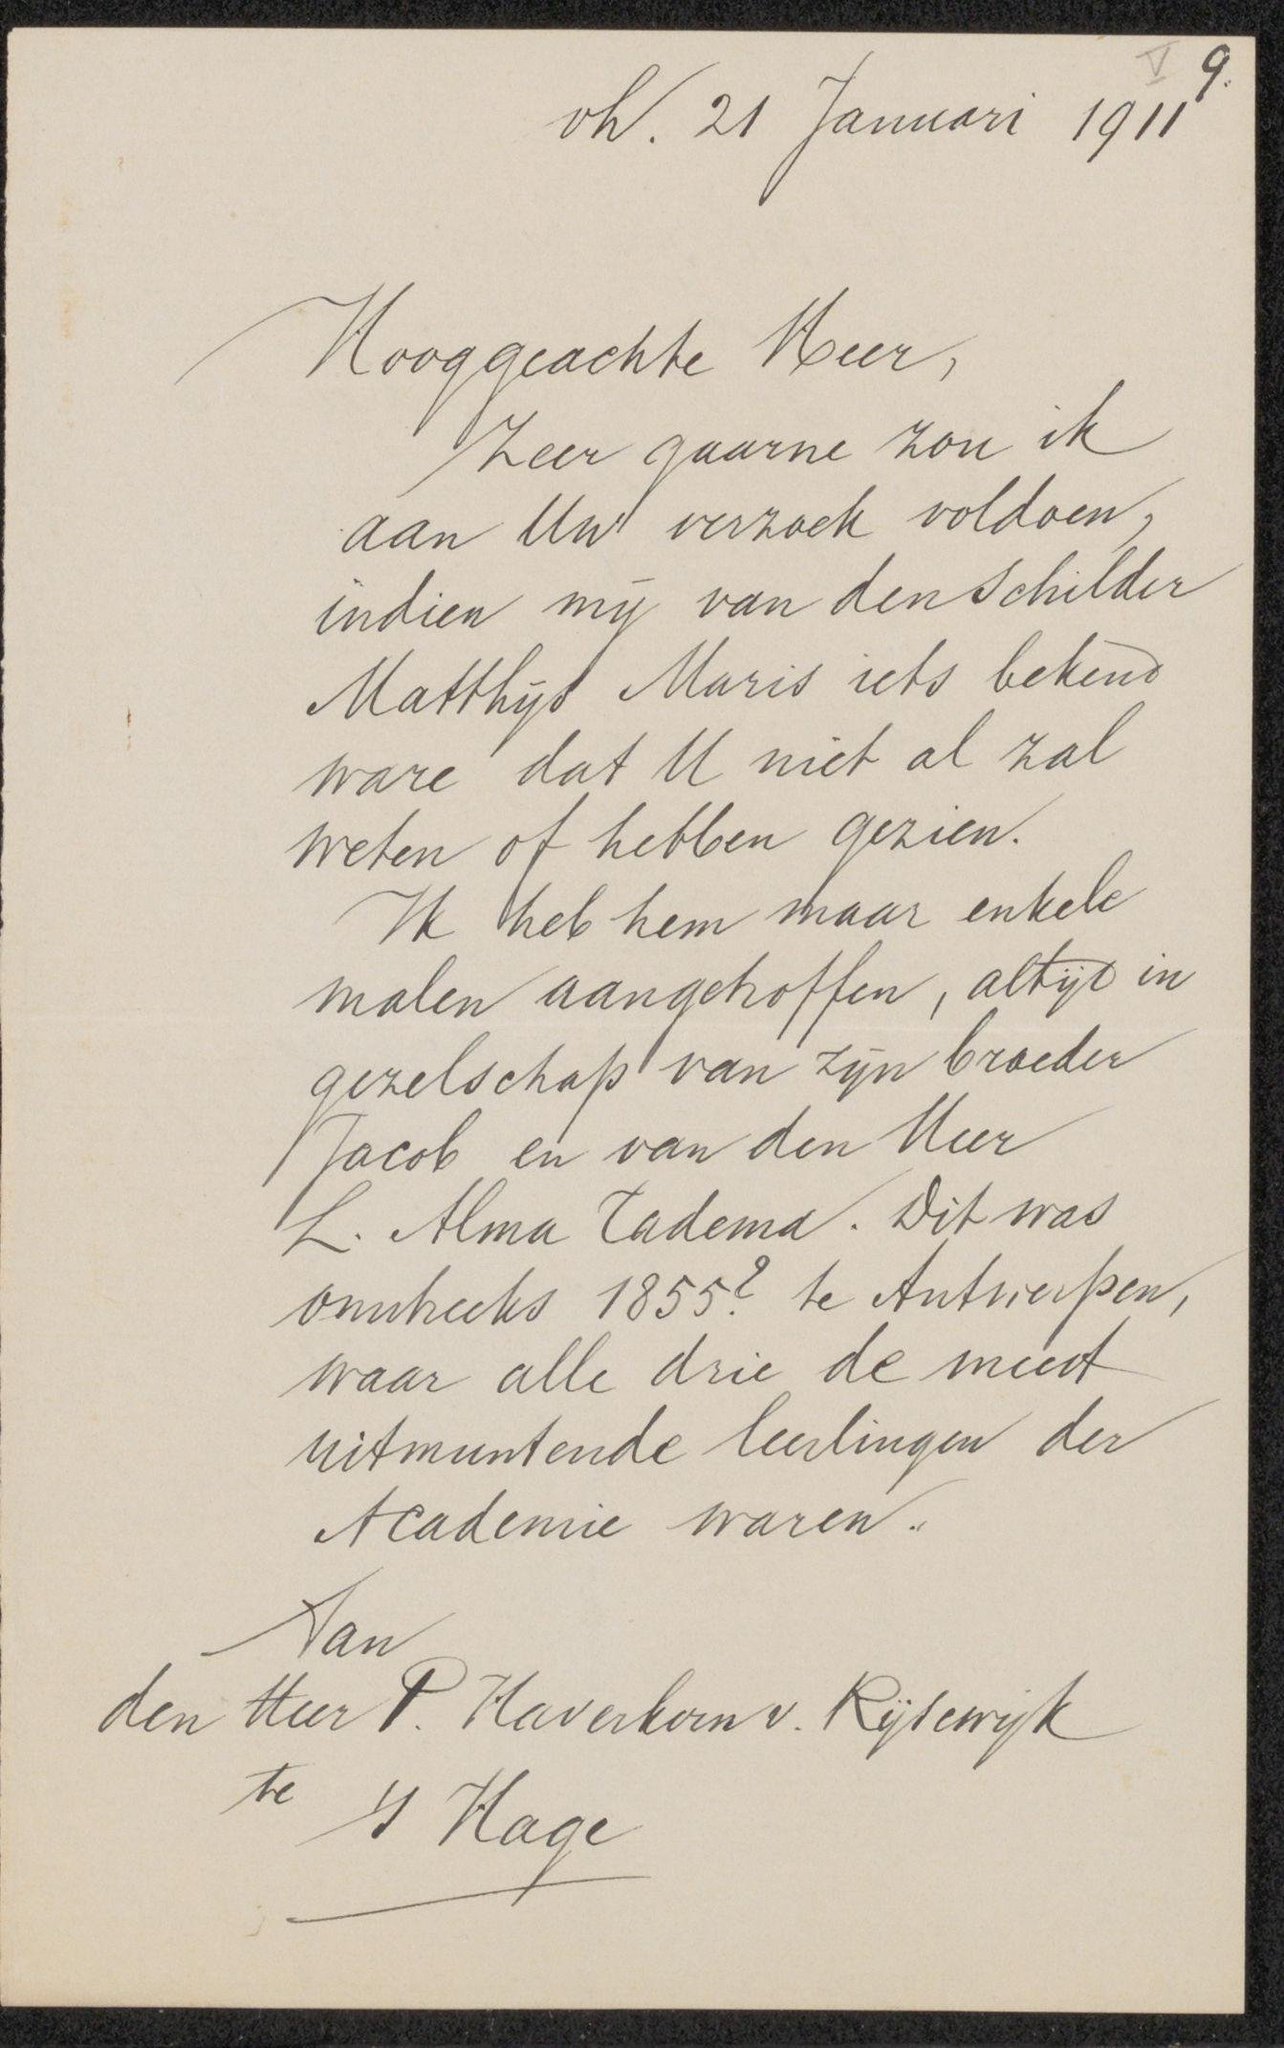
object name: letter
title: Brief aan Pieter Haverkorn van Rijsewijk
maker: august allebé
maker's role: draughtsman, print maker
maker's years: 1838-1927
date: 1911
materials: ink, paper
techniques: pen, writing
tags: lourens alma tadema, the hague, london, painter, matthijs maris, jacob maris, pieter haverkorn van rijsewijk, schools, education, tuition of the artist (in general), antwerp